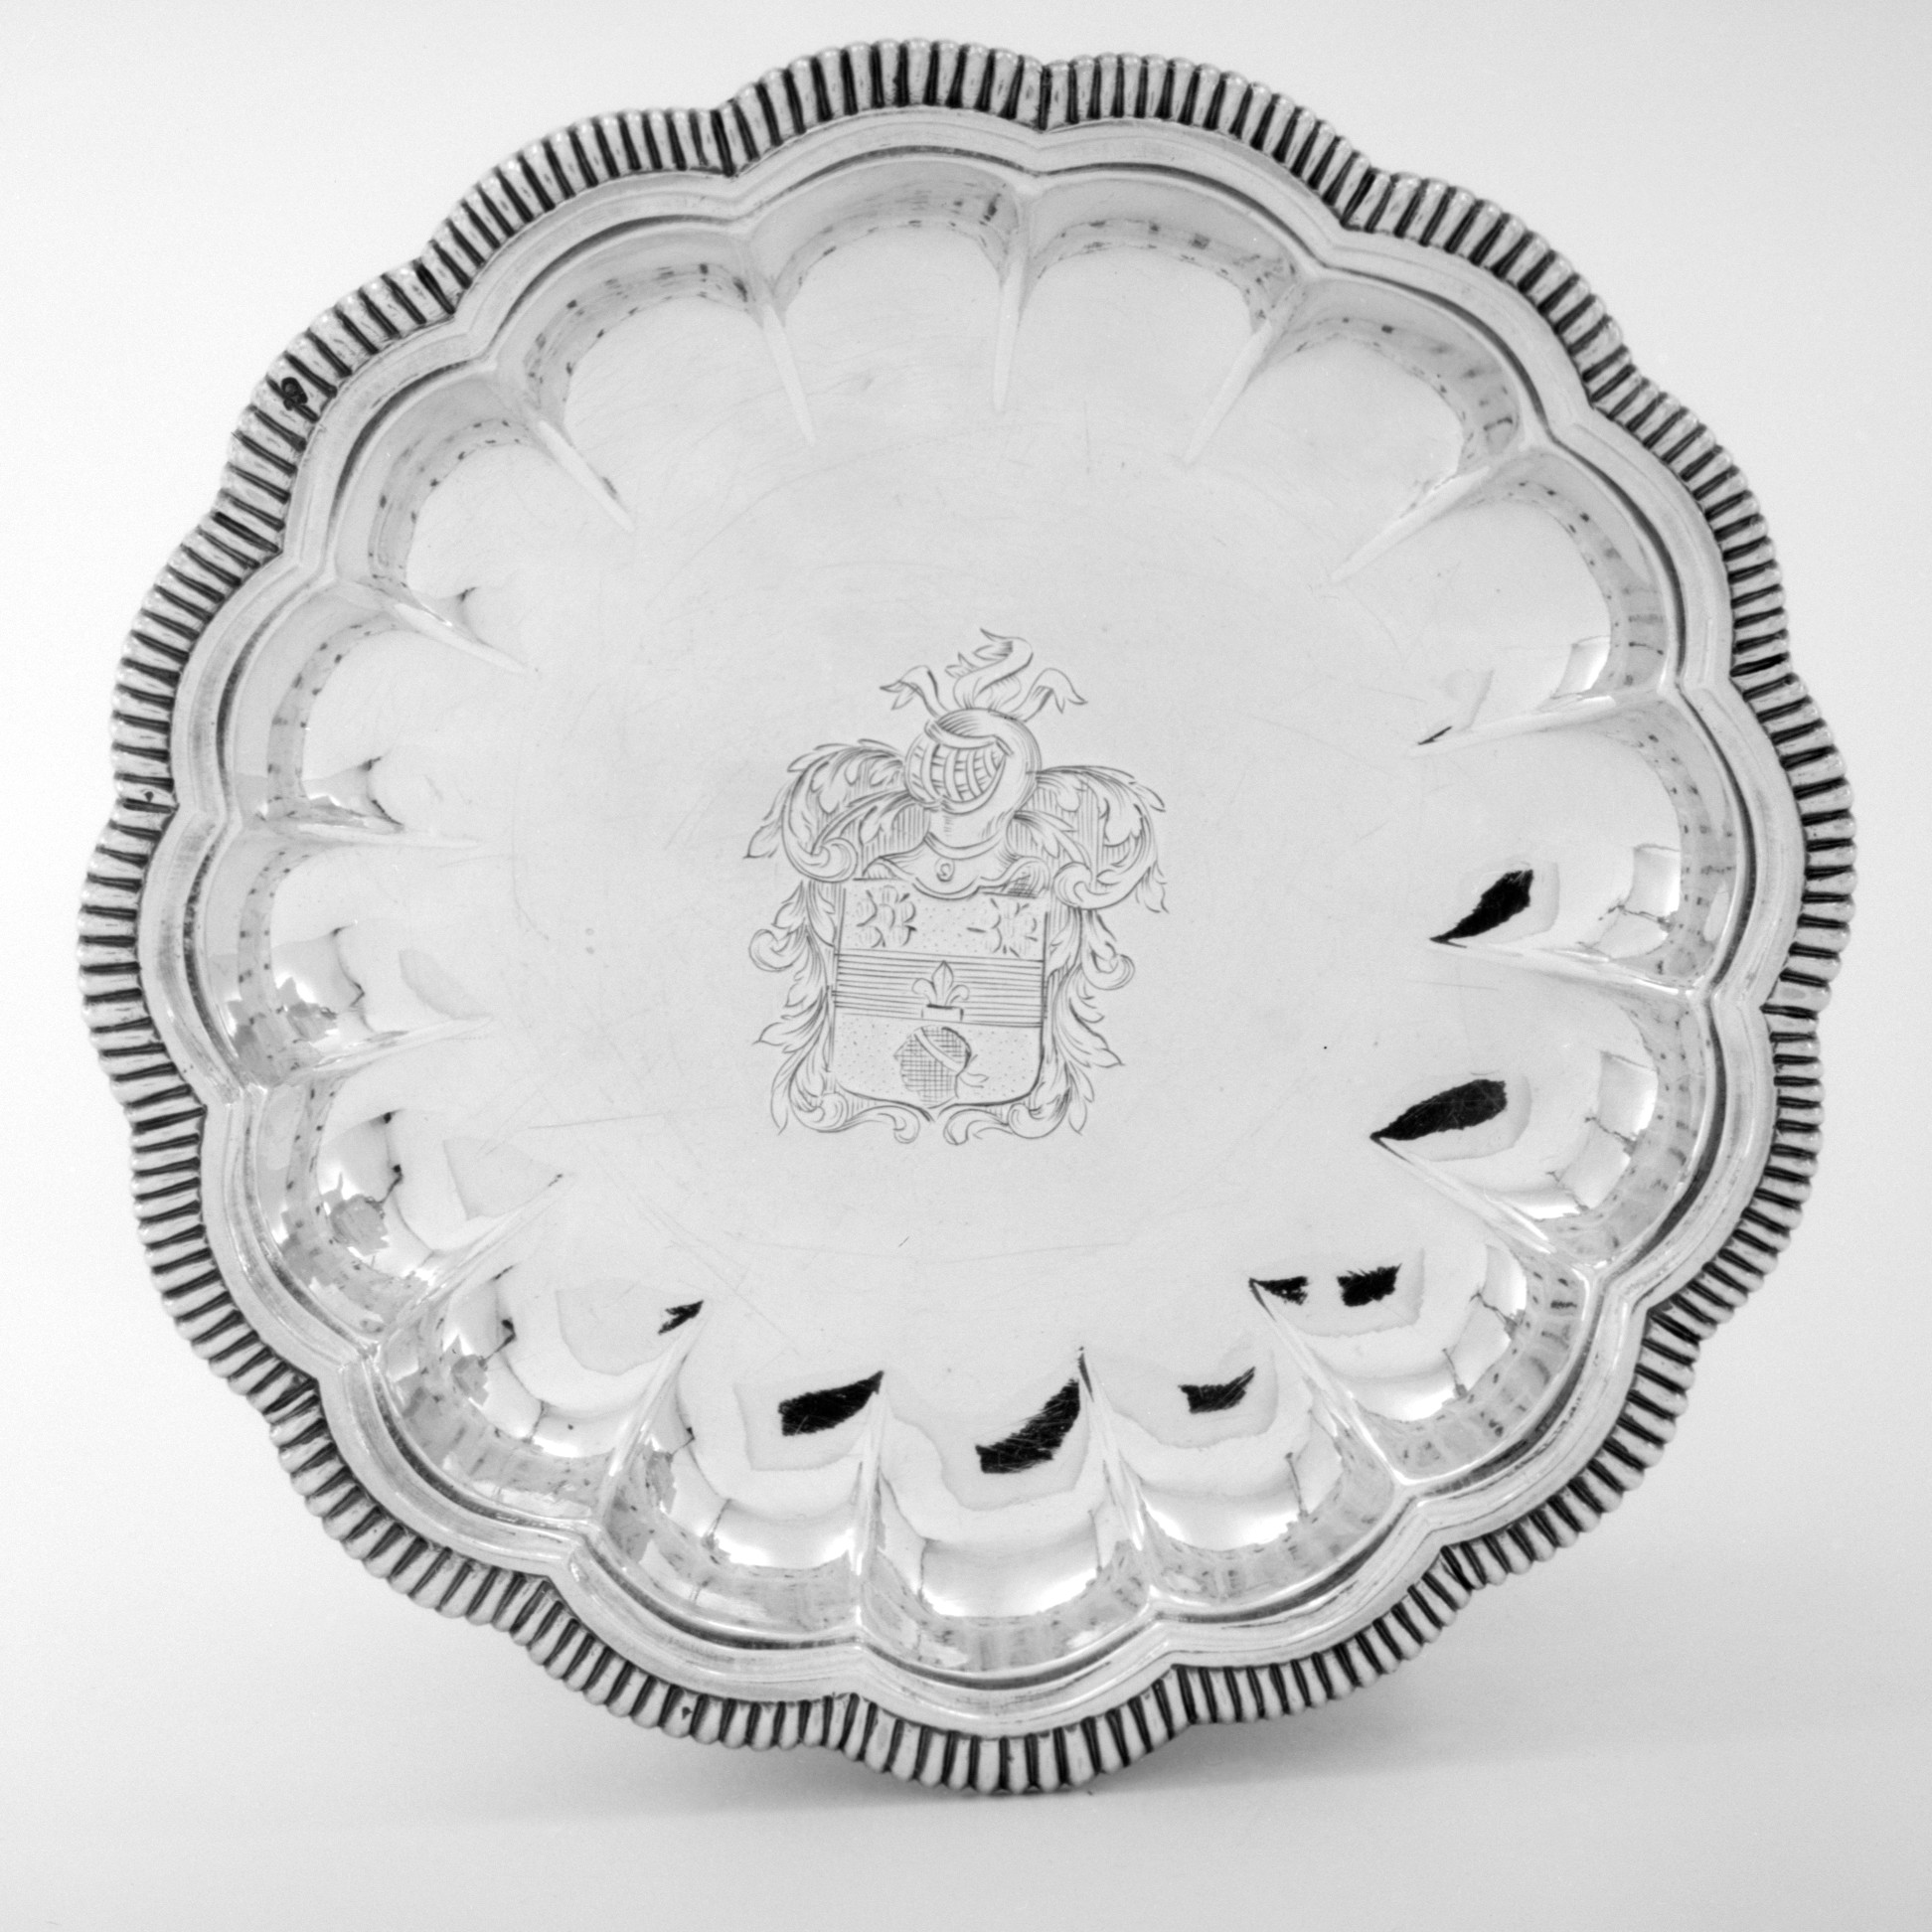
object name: dish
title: Dish (one of a pair)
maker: i d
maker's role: maker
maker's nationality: british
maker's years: 1650-1699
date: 1729-1730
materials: silver